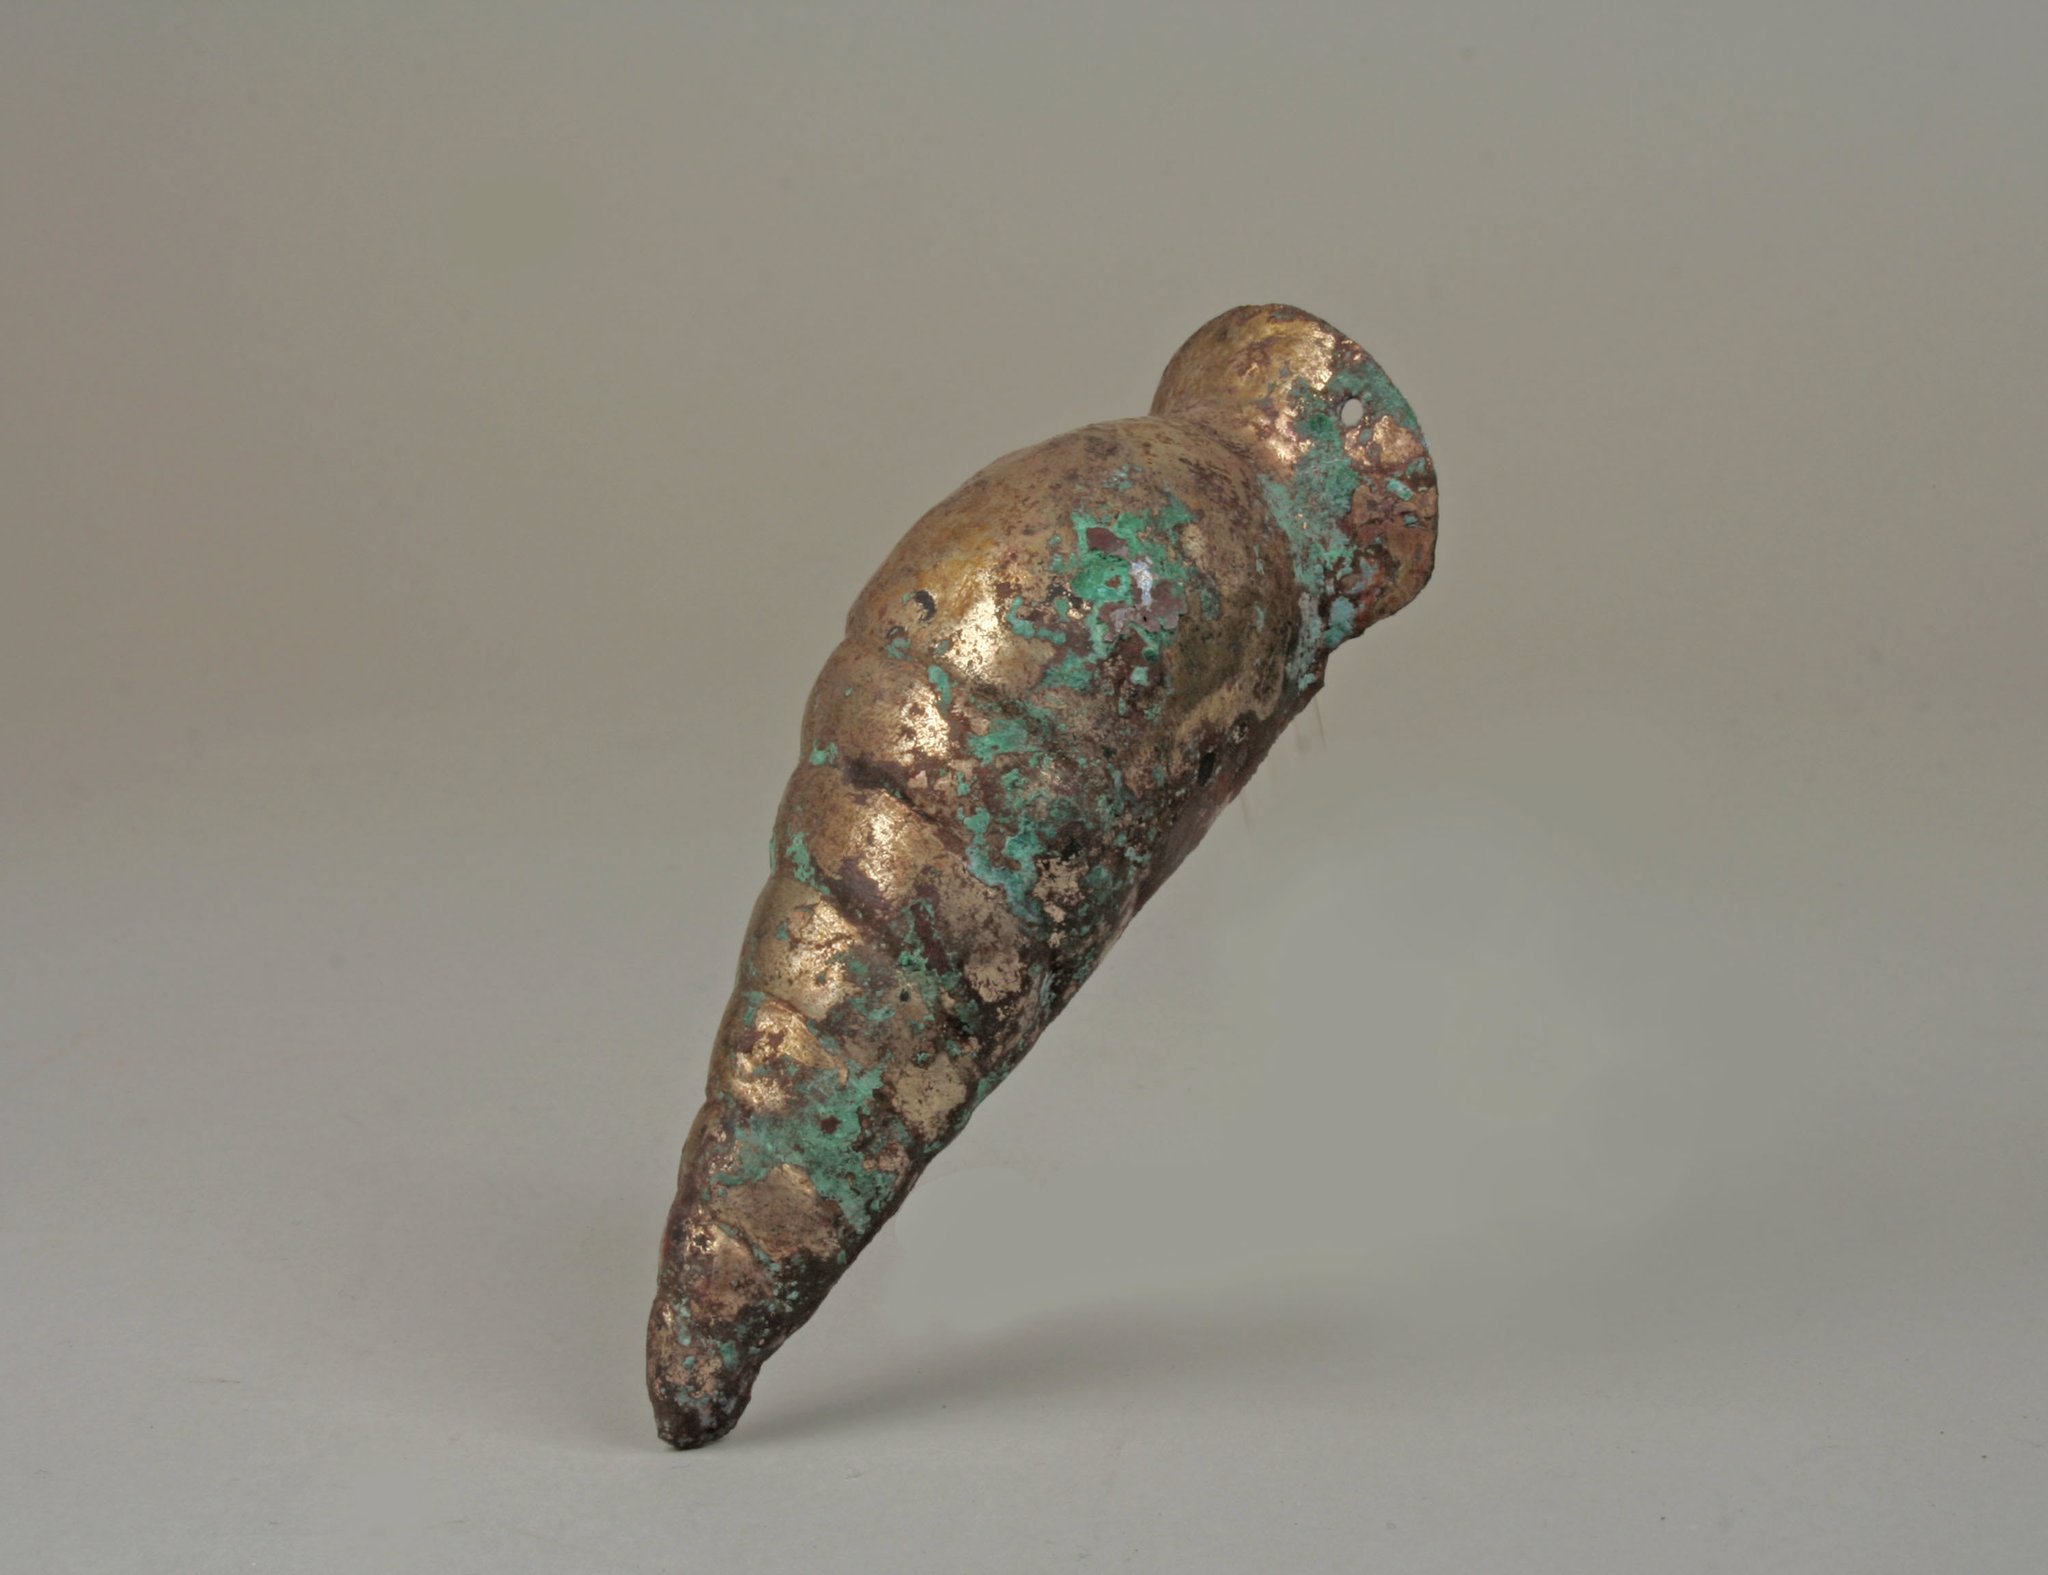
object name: ornament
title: Shell Ornaments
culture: moche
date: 501-700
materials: gilt copper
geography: peru